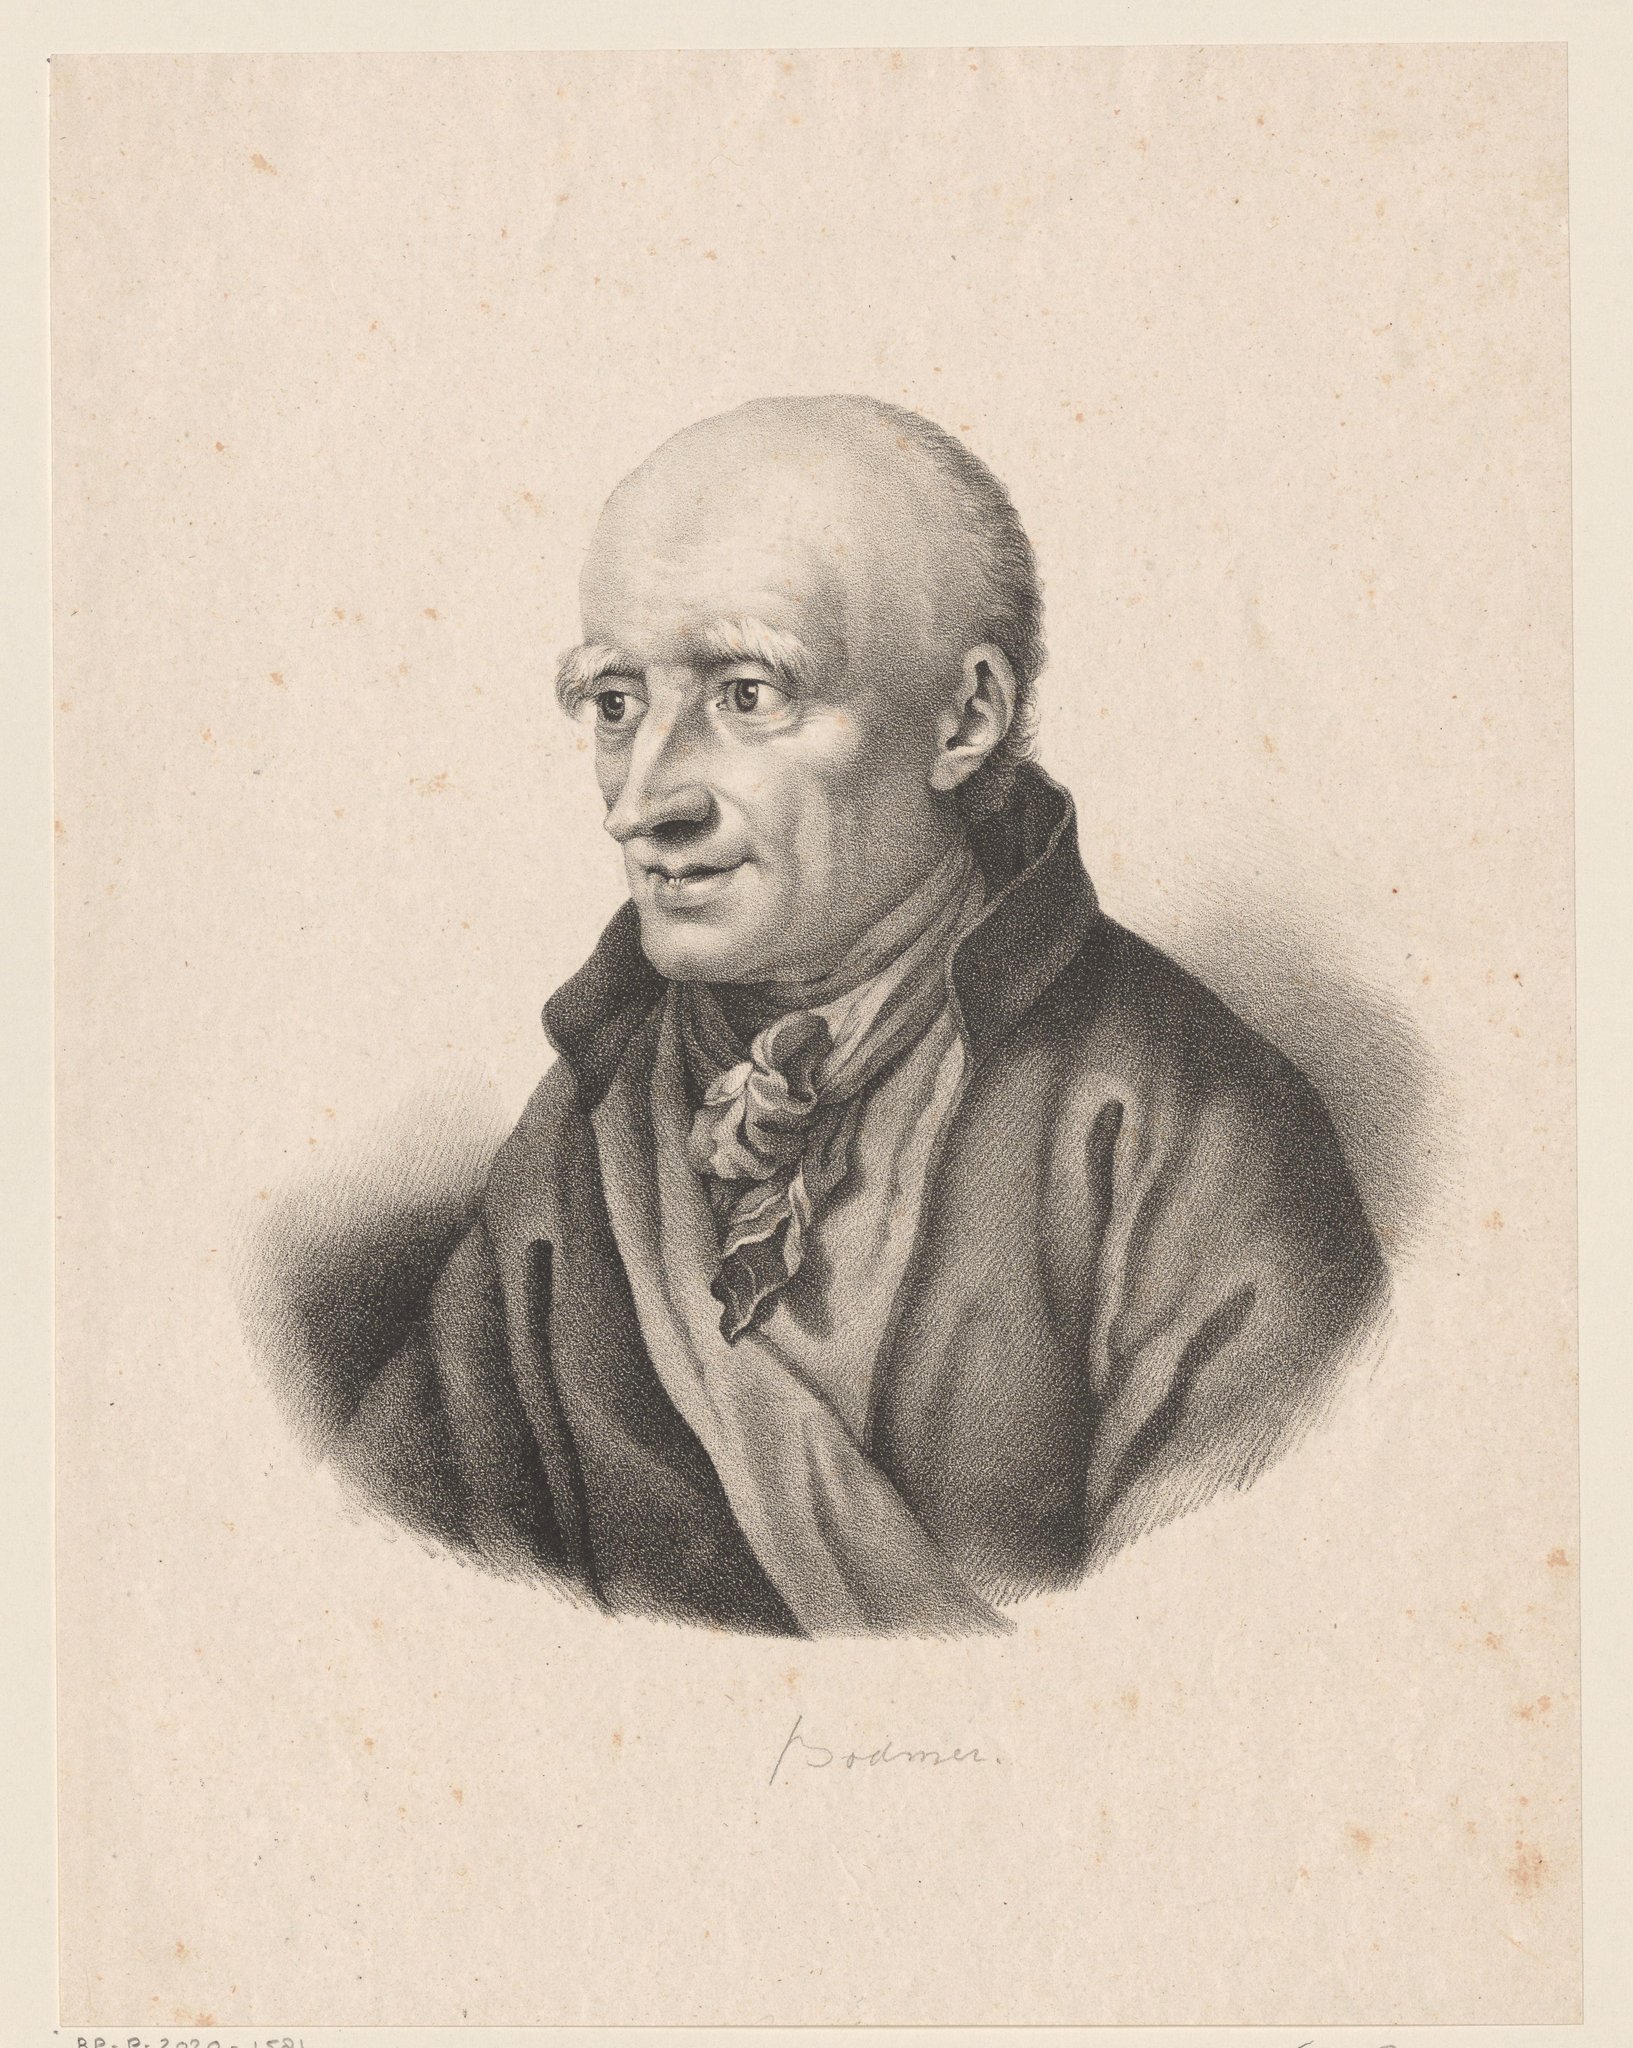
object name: print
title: Portret van Johann Jacob Bodmer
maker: emil krafft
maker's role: painter, print maker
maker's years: -1840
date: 1820-1860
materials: paper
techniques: lithograph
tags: historical persons, writer, poet, author